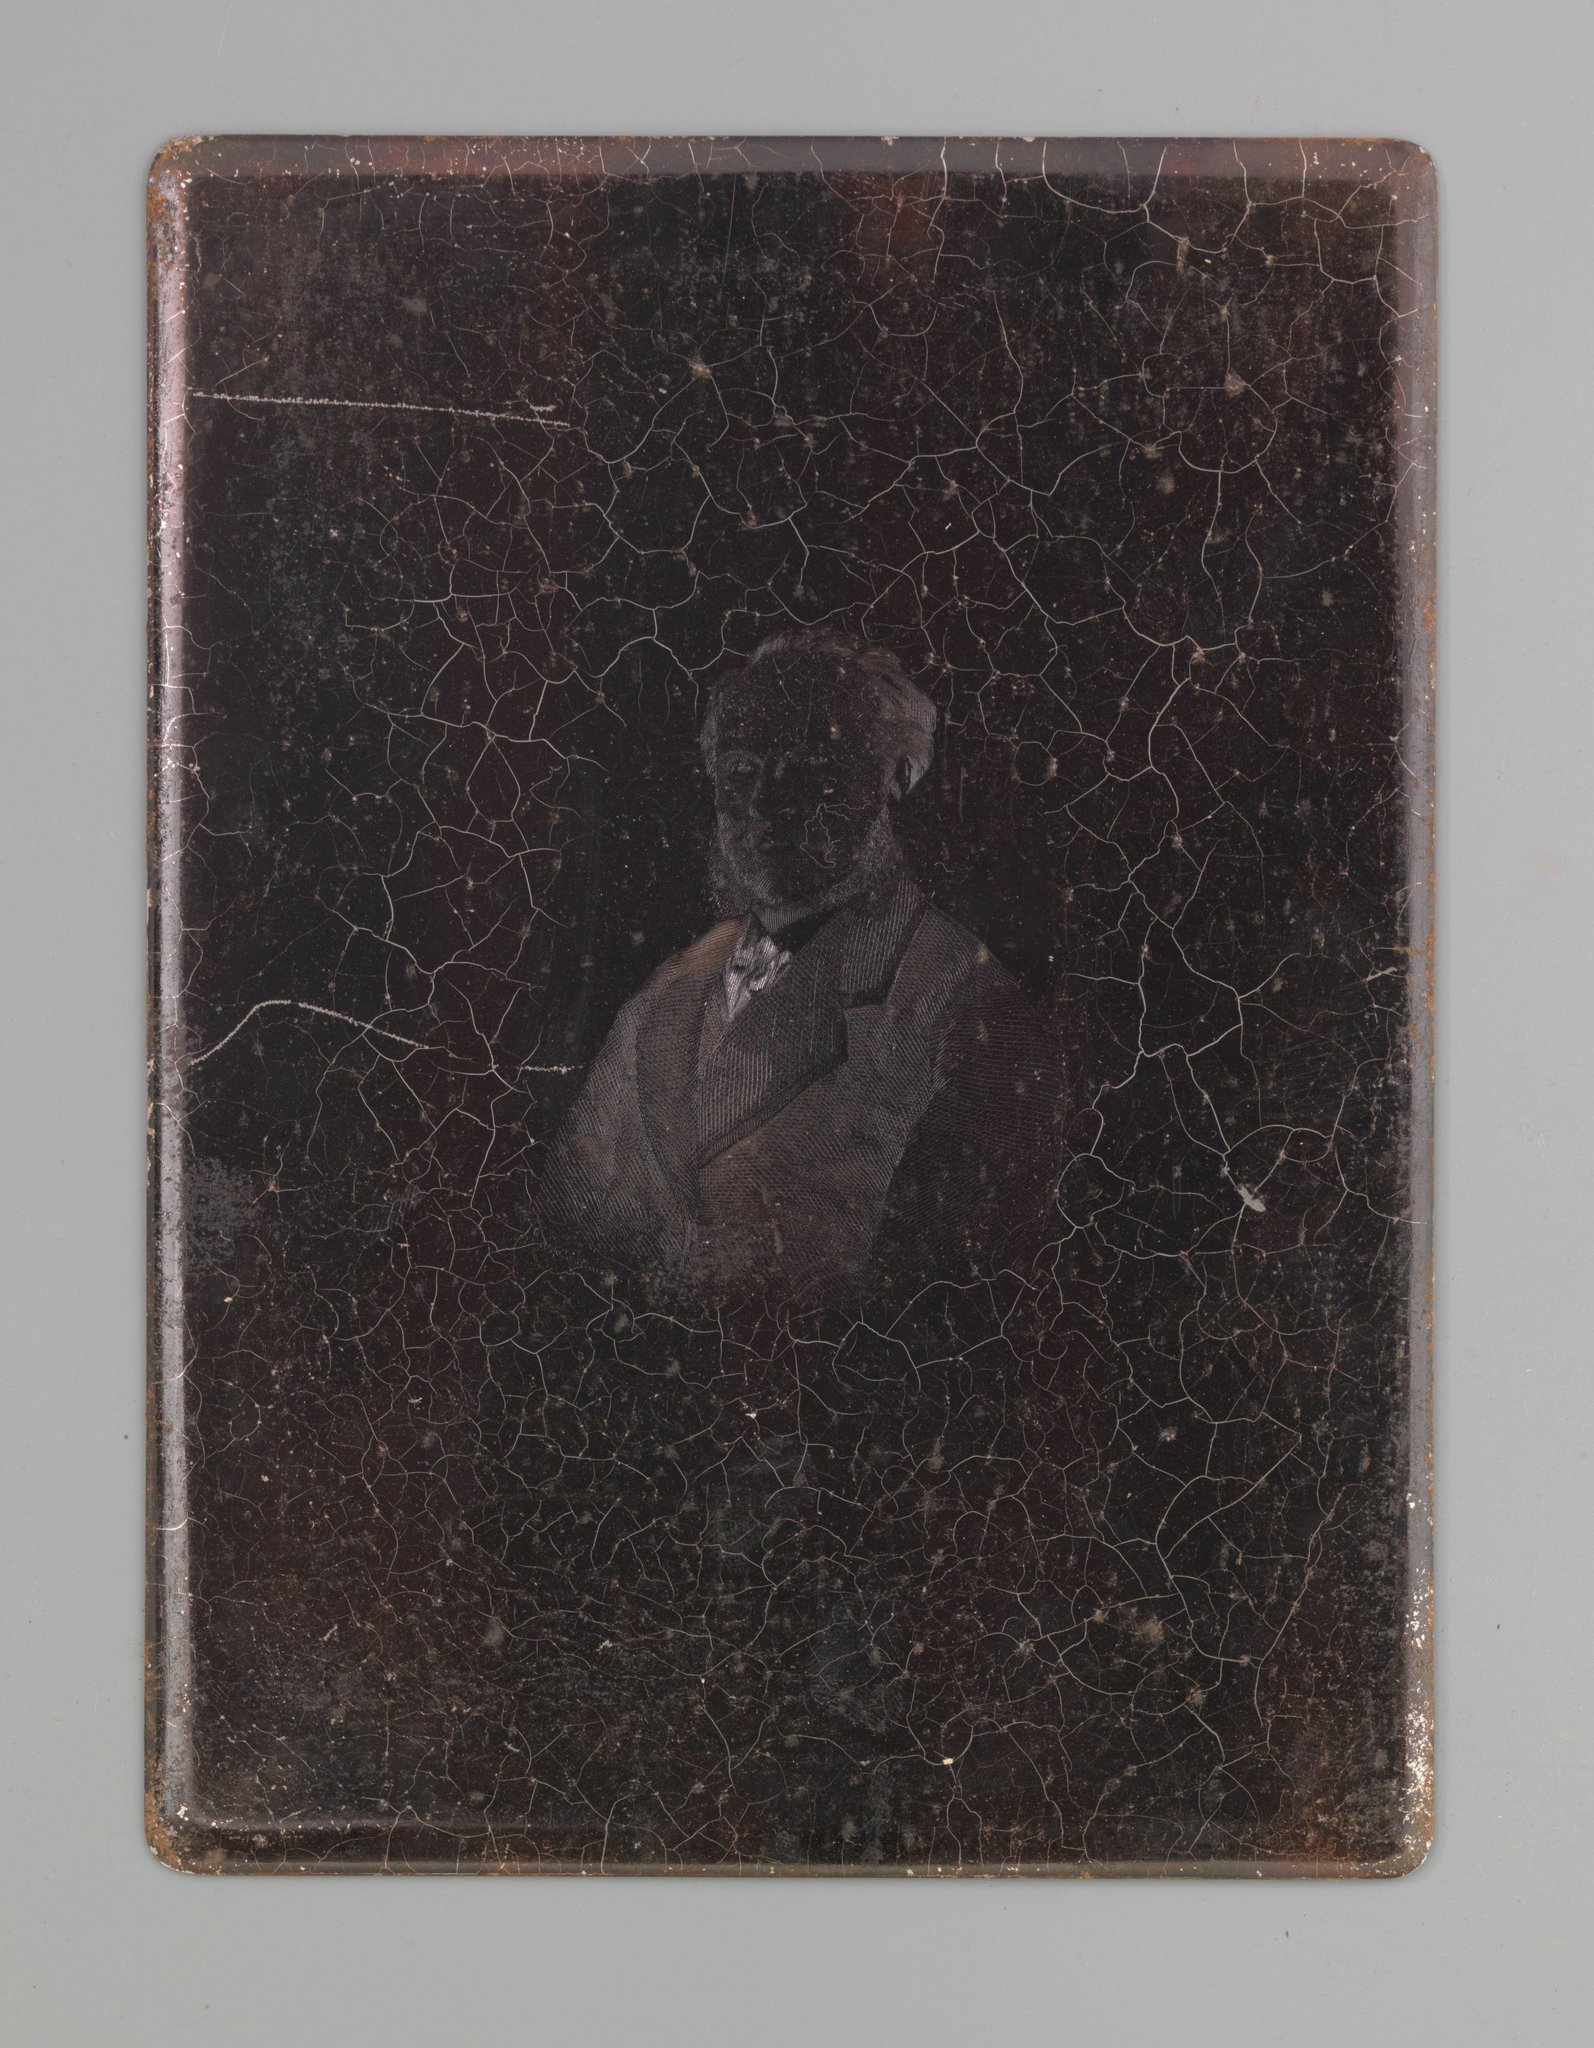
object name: staalplaat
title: Portret van G.H.F. Elliot Boswel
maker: christiaan lodewijk van kesteren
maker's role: print maker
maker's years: 1832-1897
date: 1842-1897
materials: steel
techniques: engraving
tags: george henry james elliot boswel